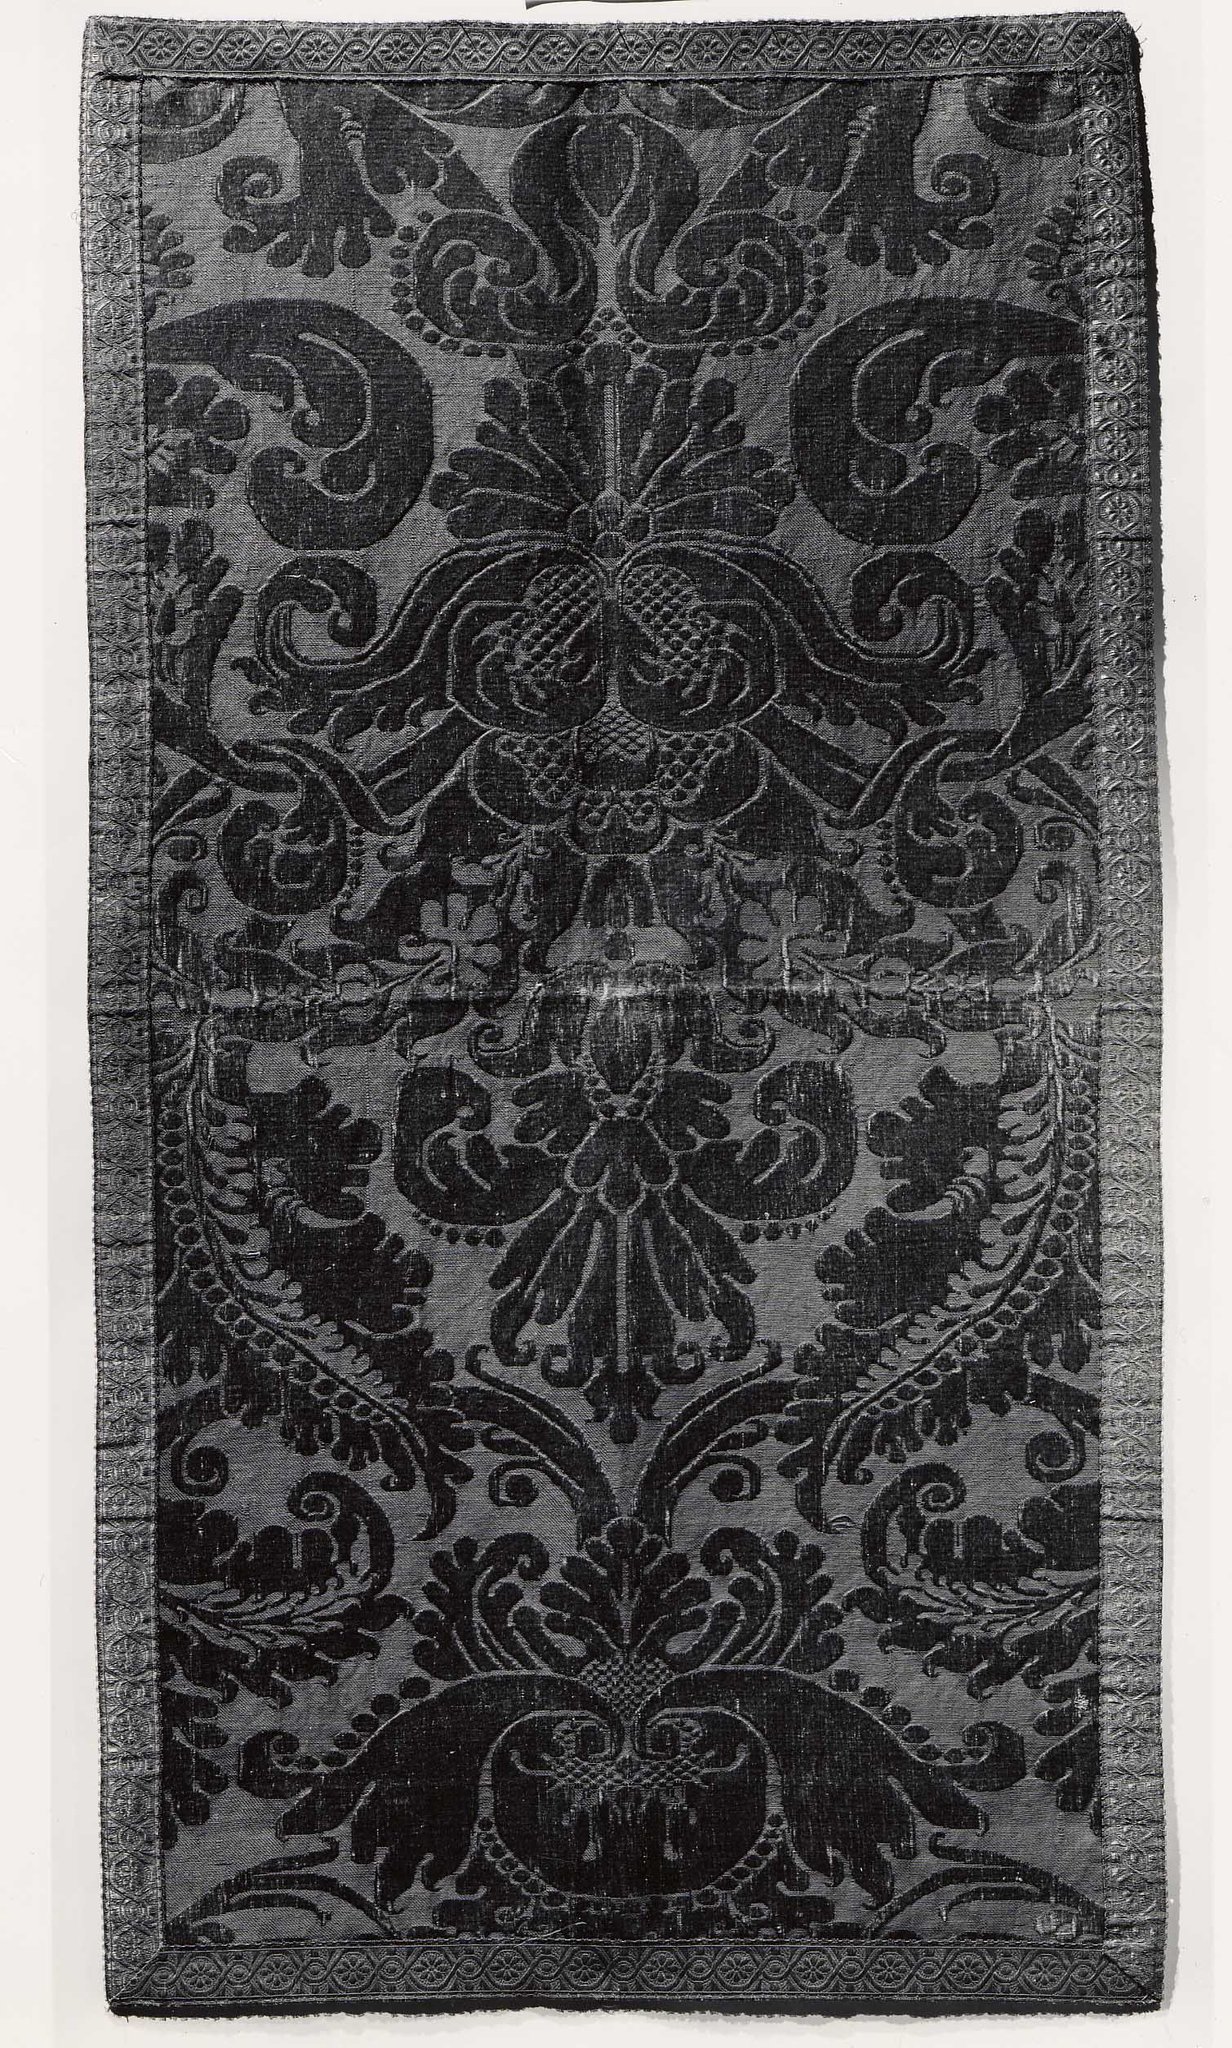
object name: textile cover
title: Cover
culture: italian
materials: cotton, linen, metal, silk